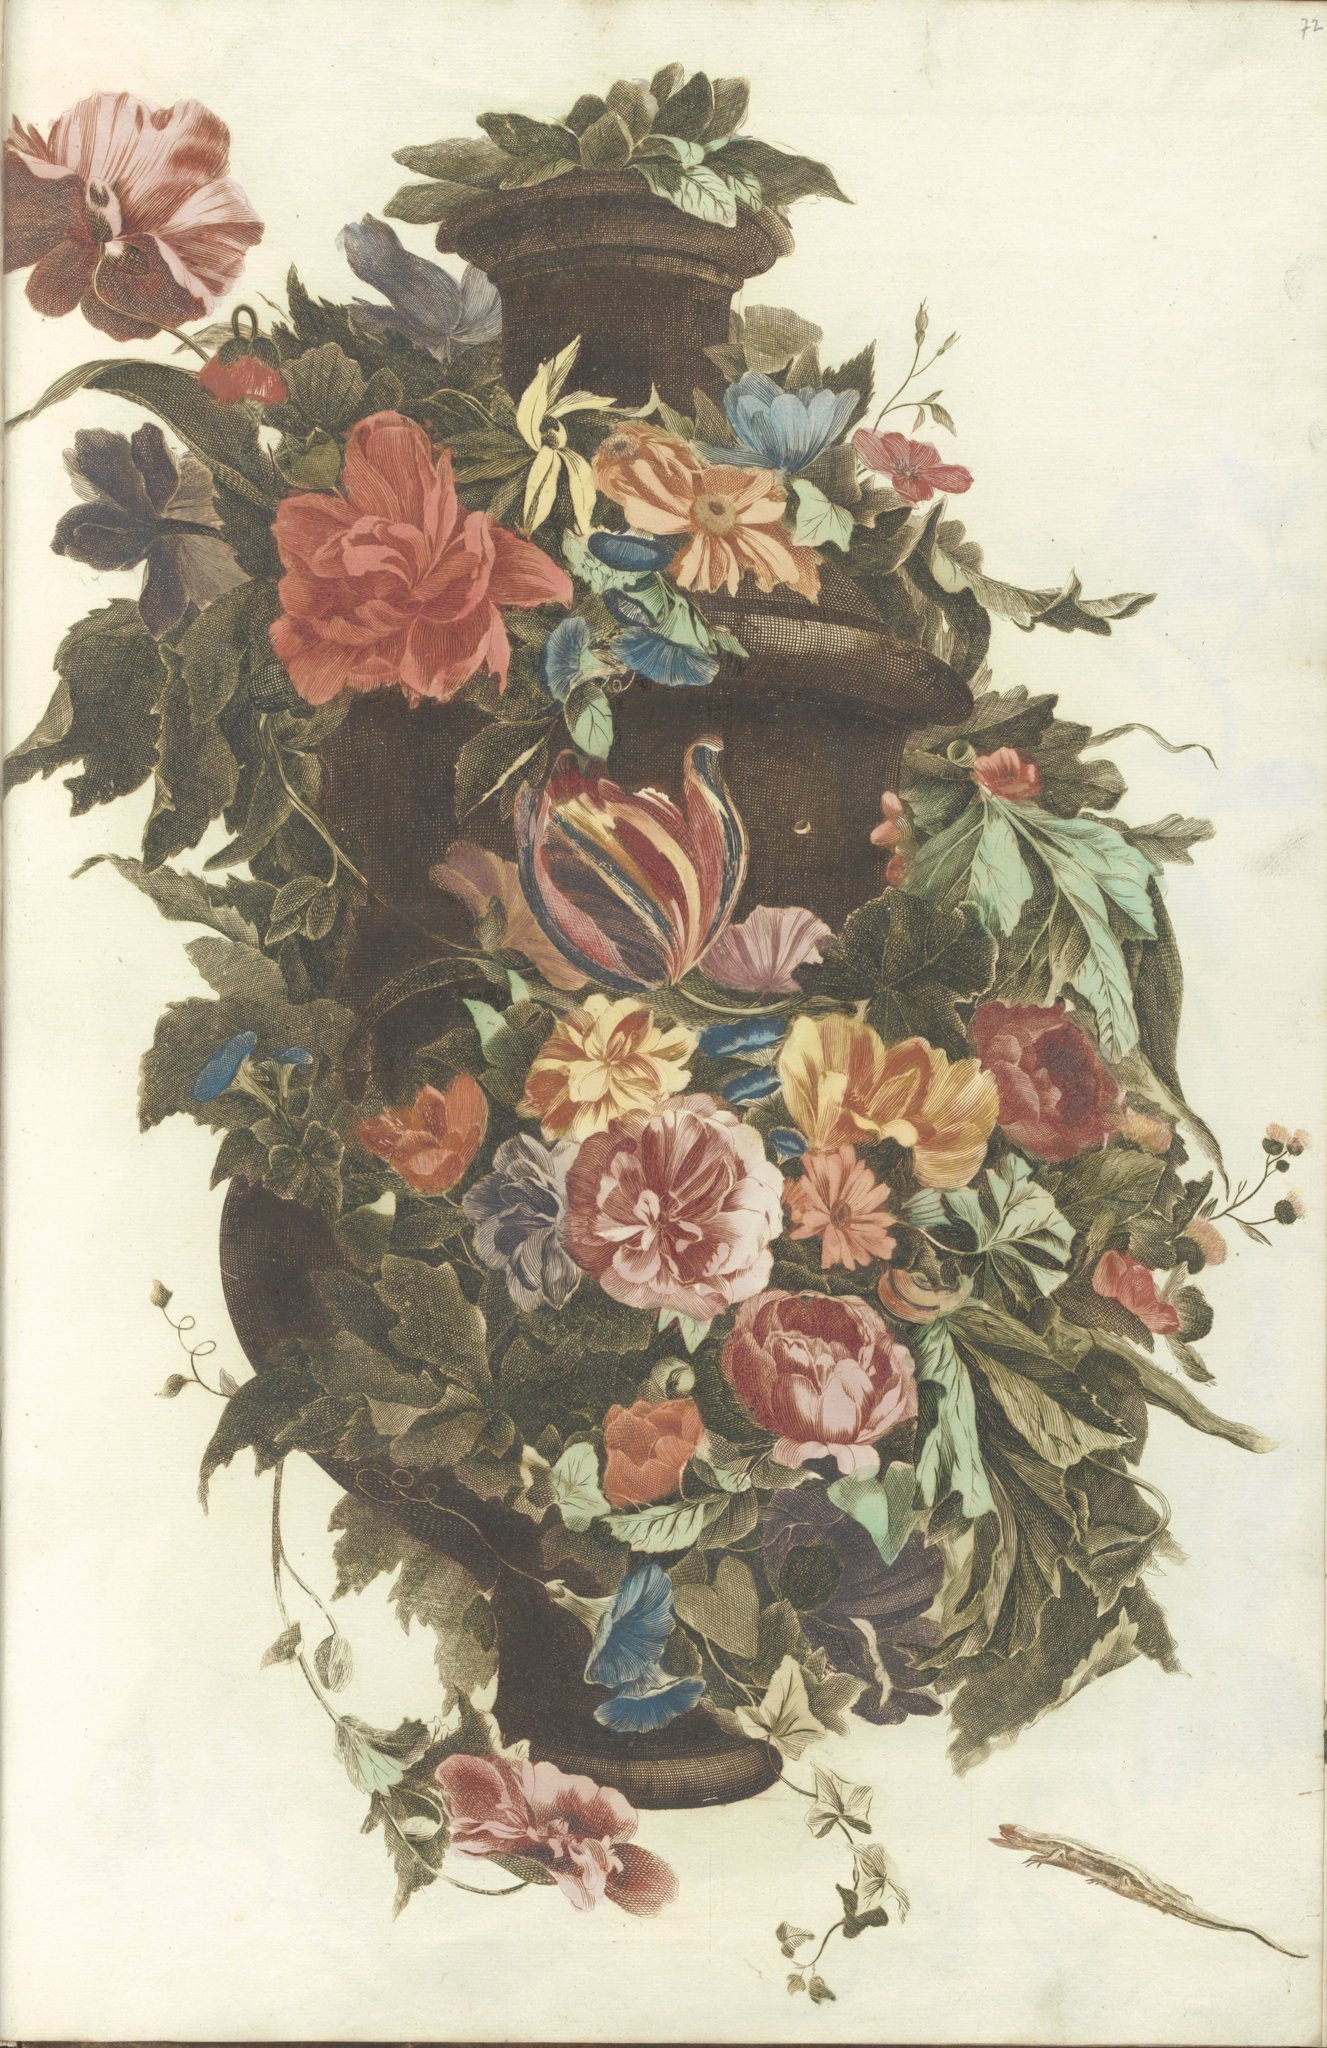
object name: print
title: Vaas omgeven door bloemenguirlande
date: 1688-1698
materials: paper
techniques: printing, engraving, hand coloring, lithography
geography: netherlands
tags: garland, wreath, vase ~ ornament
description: Een door een bloemenguirlande omgeven vaas. Rechts een hagedis. Deze prent maakt deel uit van een album.